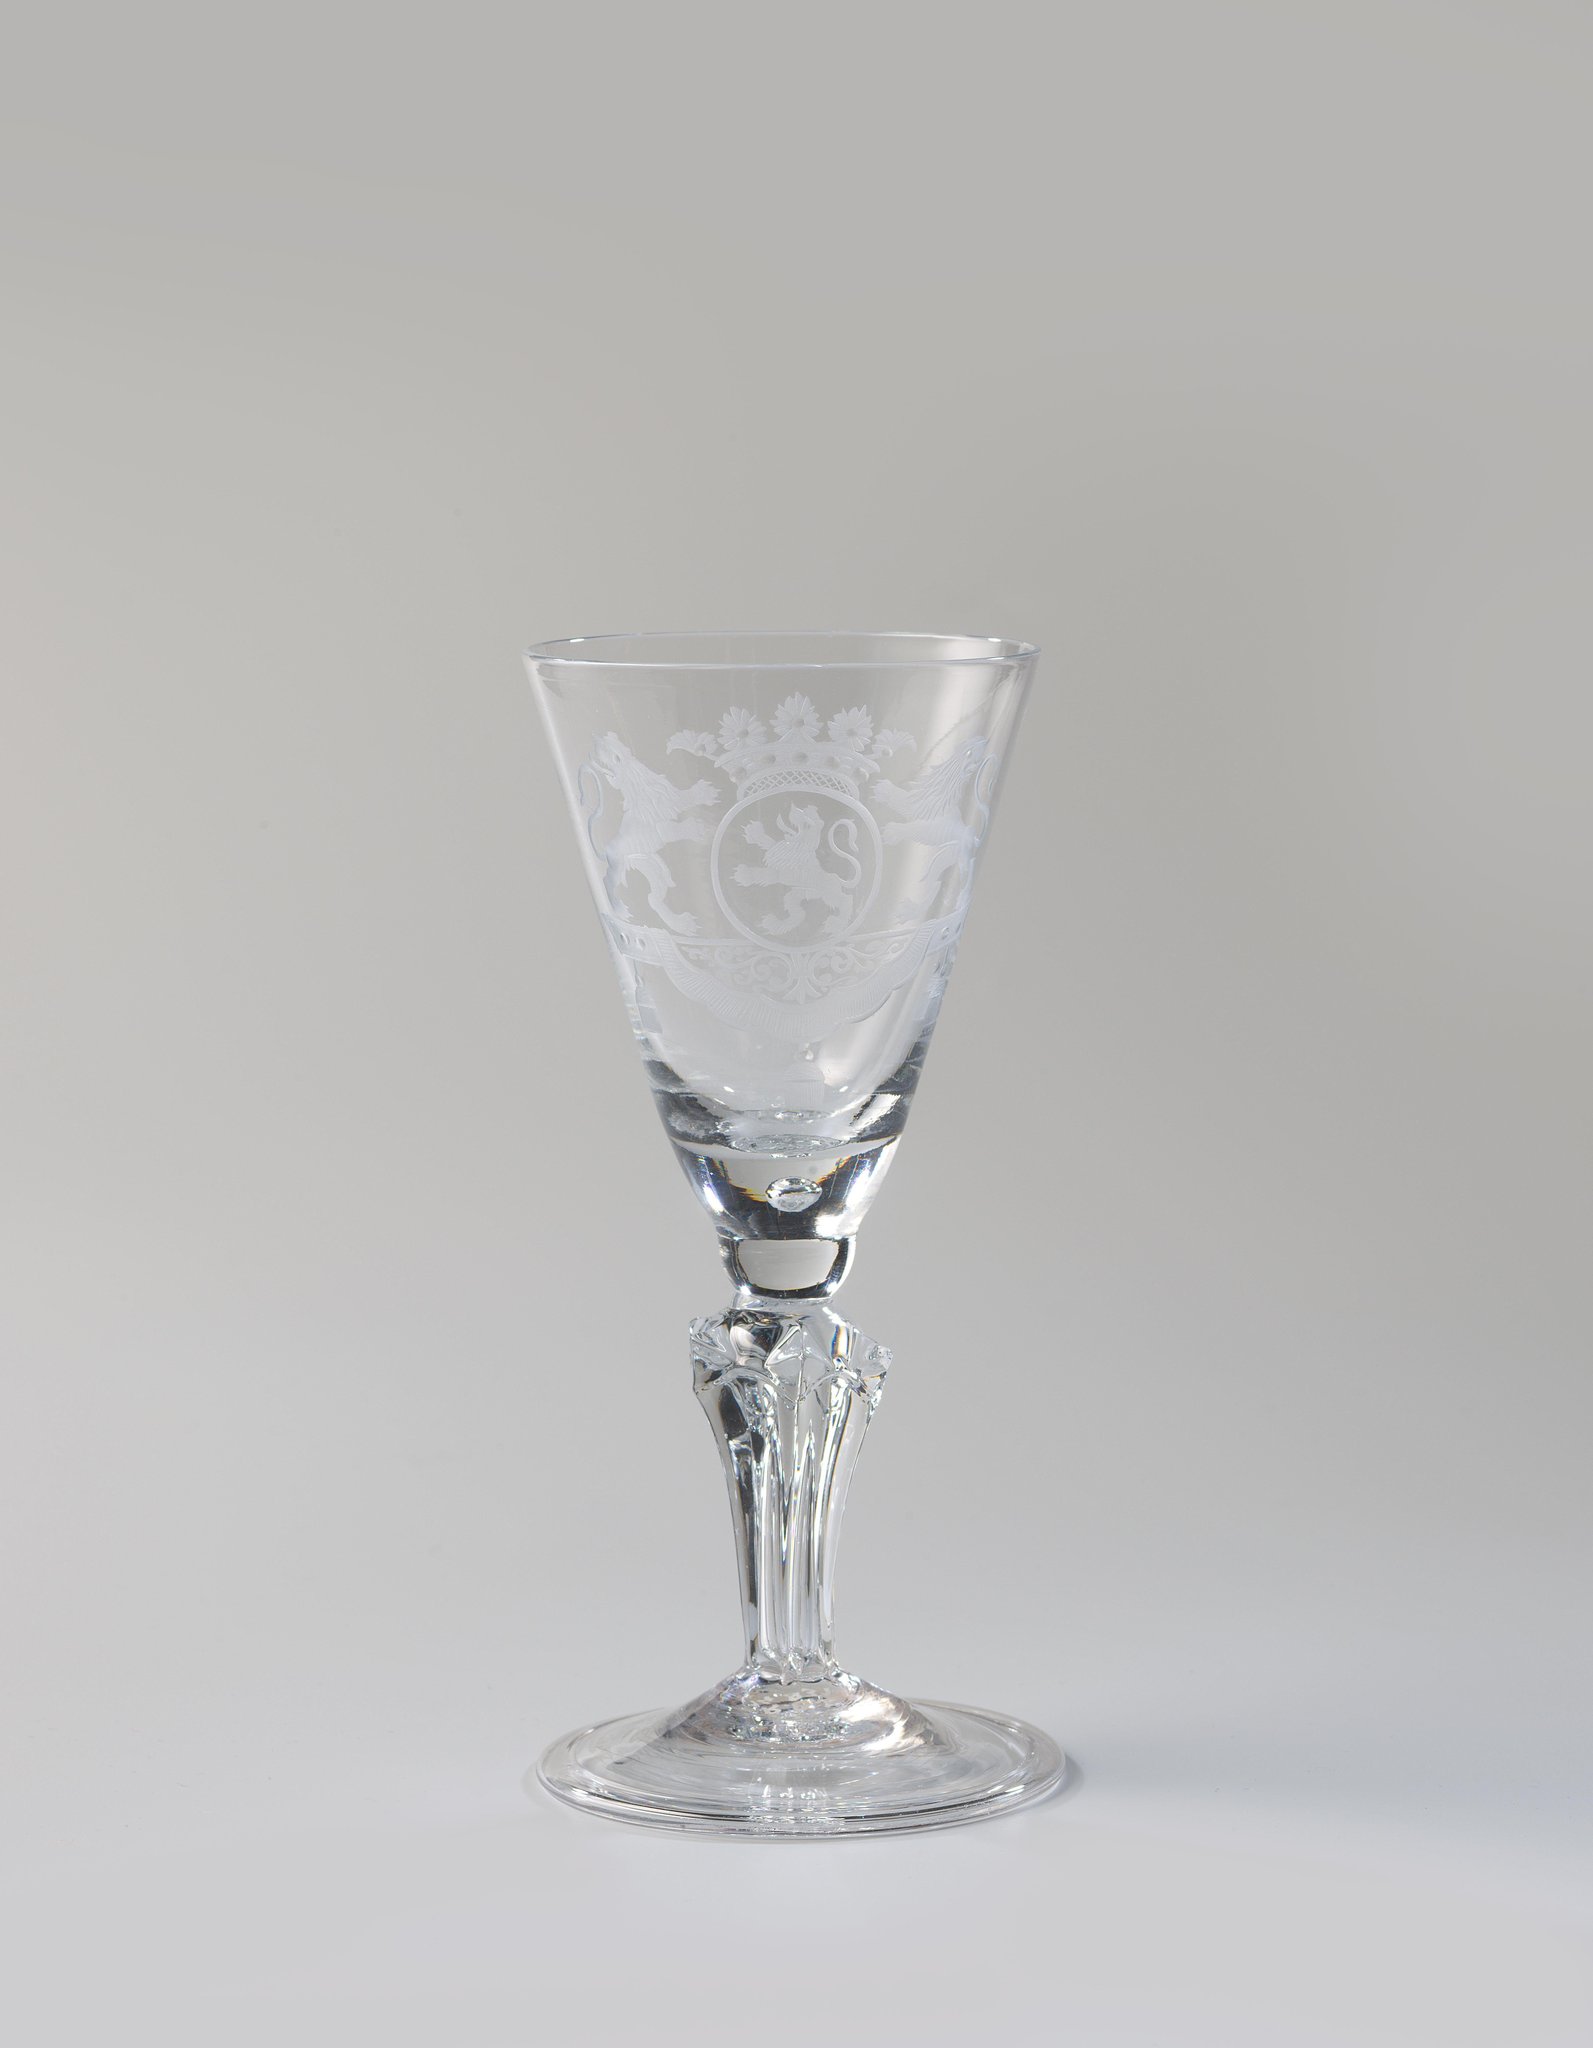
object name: goblet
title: Kelkglas met het wapen van de provincie Holland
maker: Anonymous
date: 1725-1750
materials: glass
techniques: glassblowing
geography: england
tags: provincie holland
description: Conische voet met omgeslagen rand. De stam samengesteld uit een knop, een achtzijdige , geribde balustervormige stam met acht diamanten op de schouder. Trechtervormige kelk met een afgeronde, verdikte bodem met luchtbel. Op de kelk, op een lambrequin met franje, het gekroonde wapen van de provincie Holland in een cirkelvormige schild, geflankeerd door twee leeuwen.